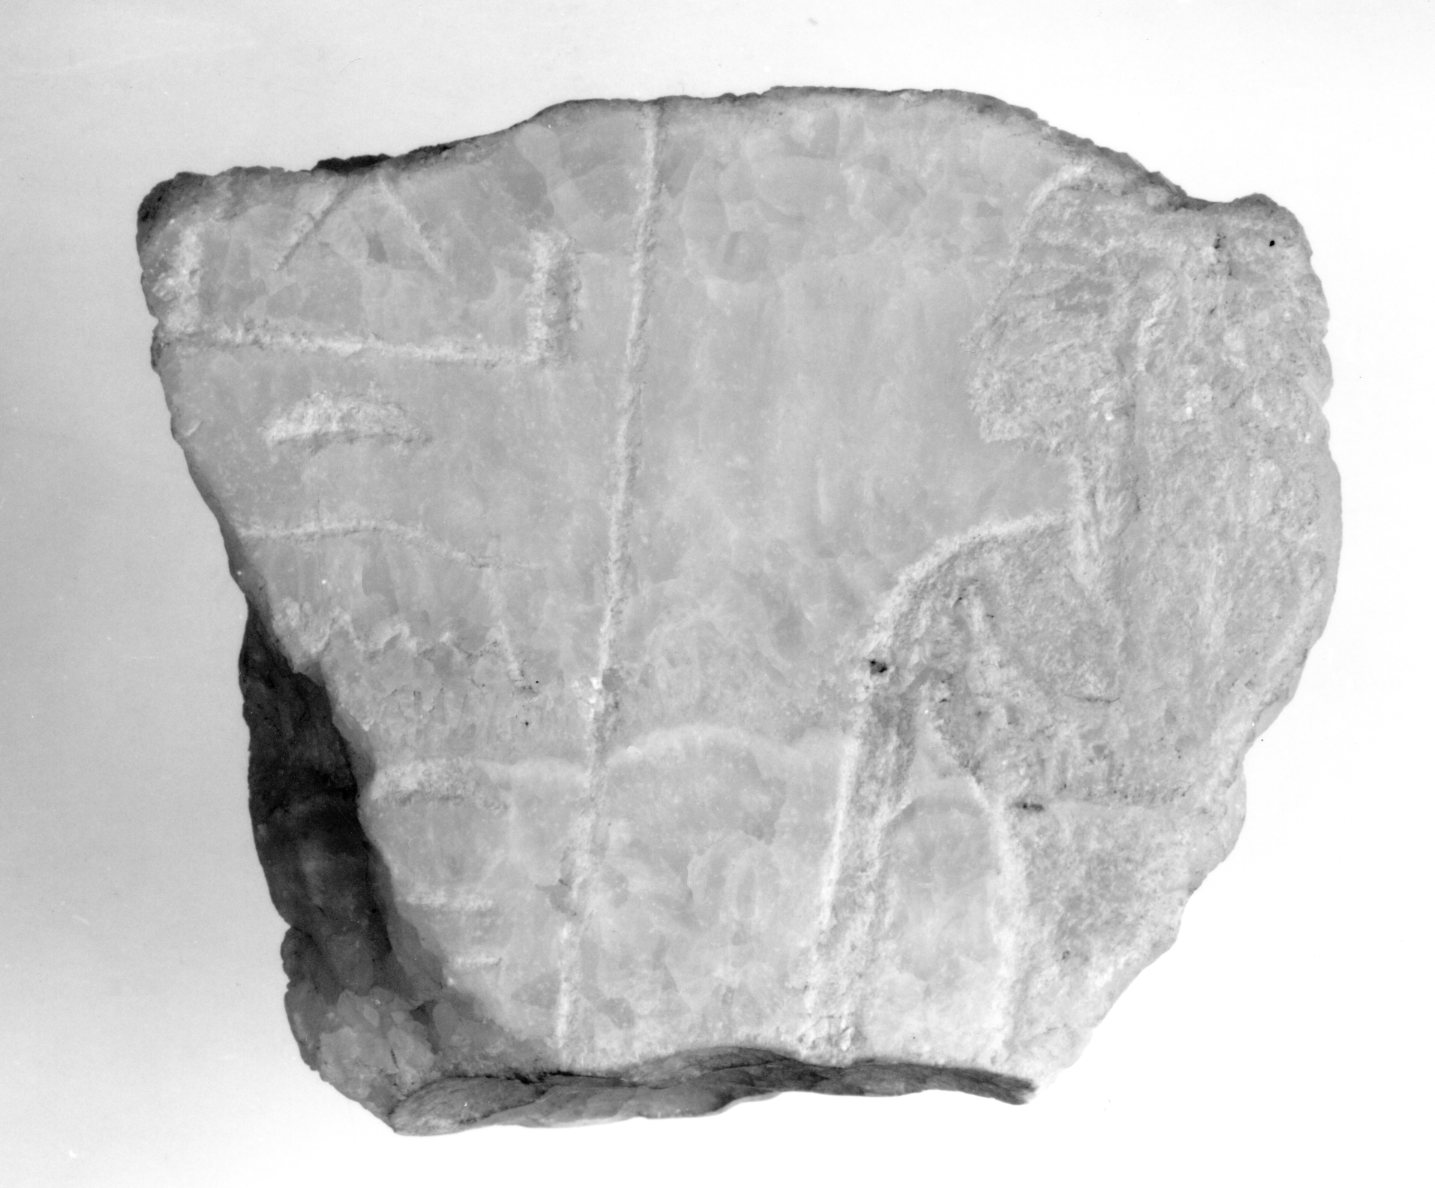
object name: canopic chest, tiye, thutmose iv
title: Fragment of a Canopic Chest of Queen Tiya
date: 1427-1390 BCE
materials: stone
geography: egypt